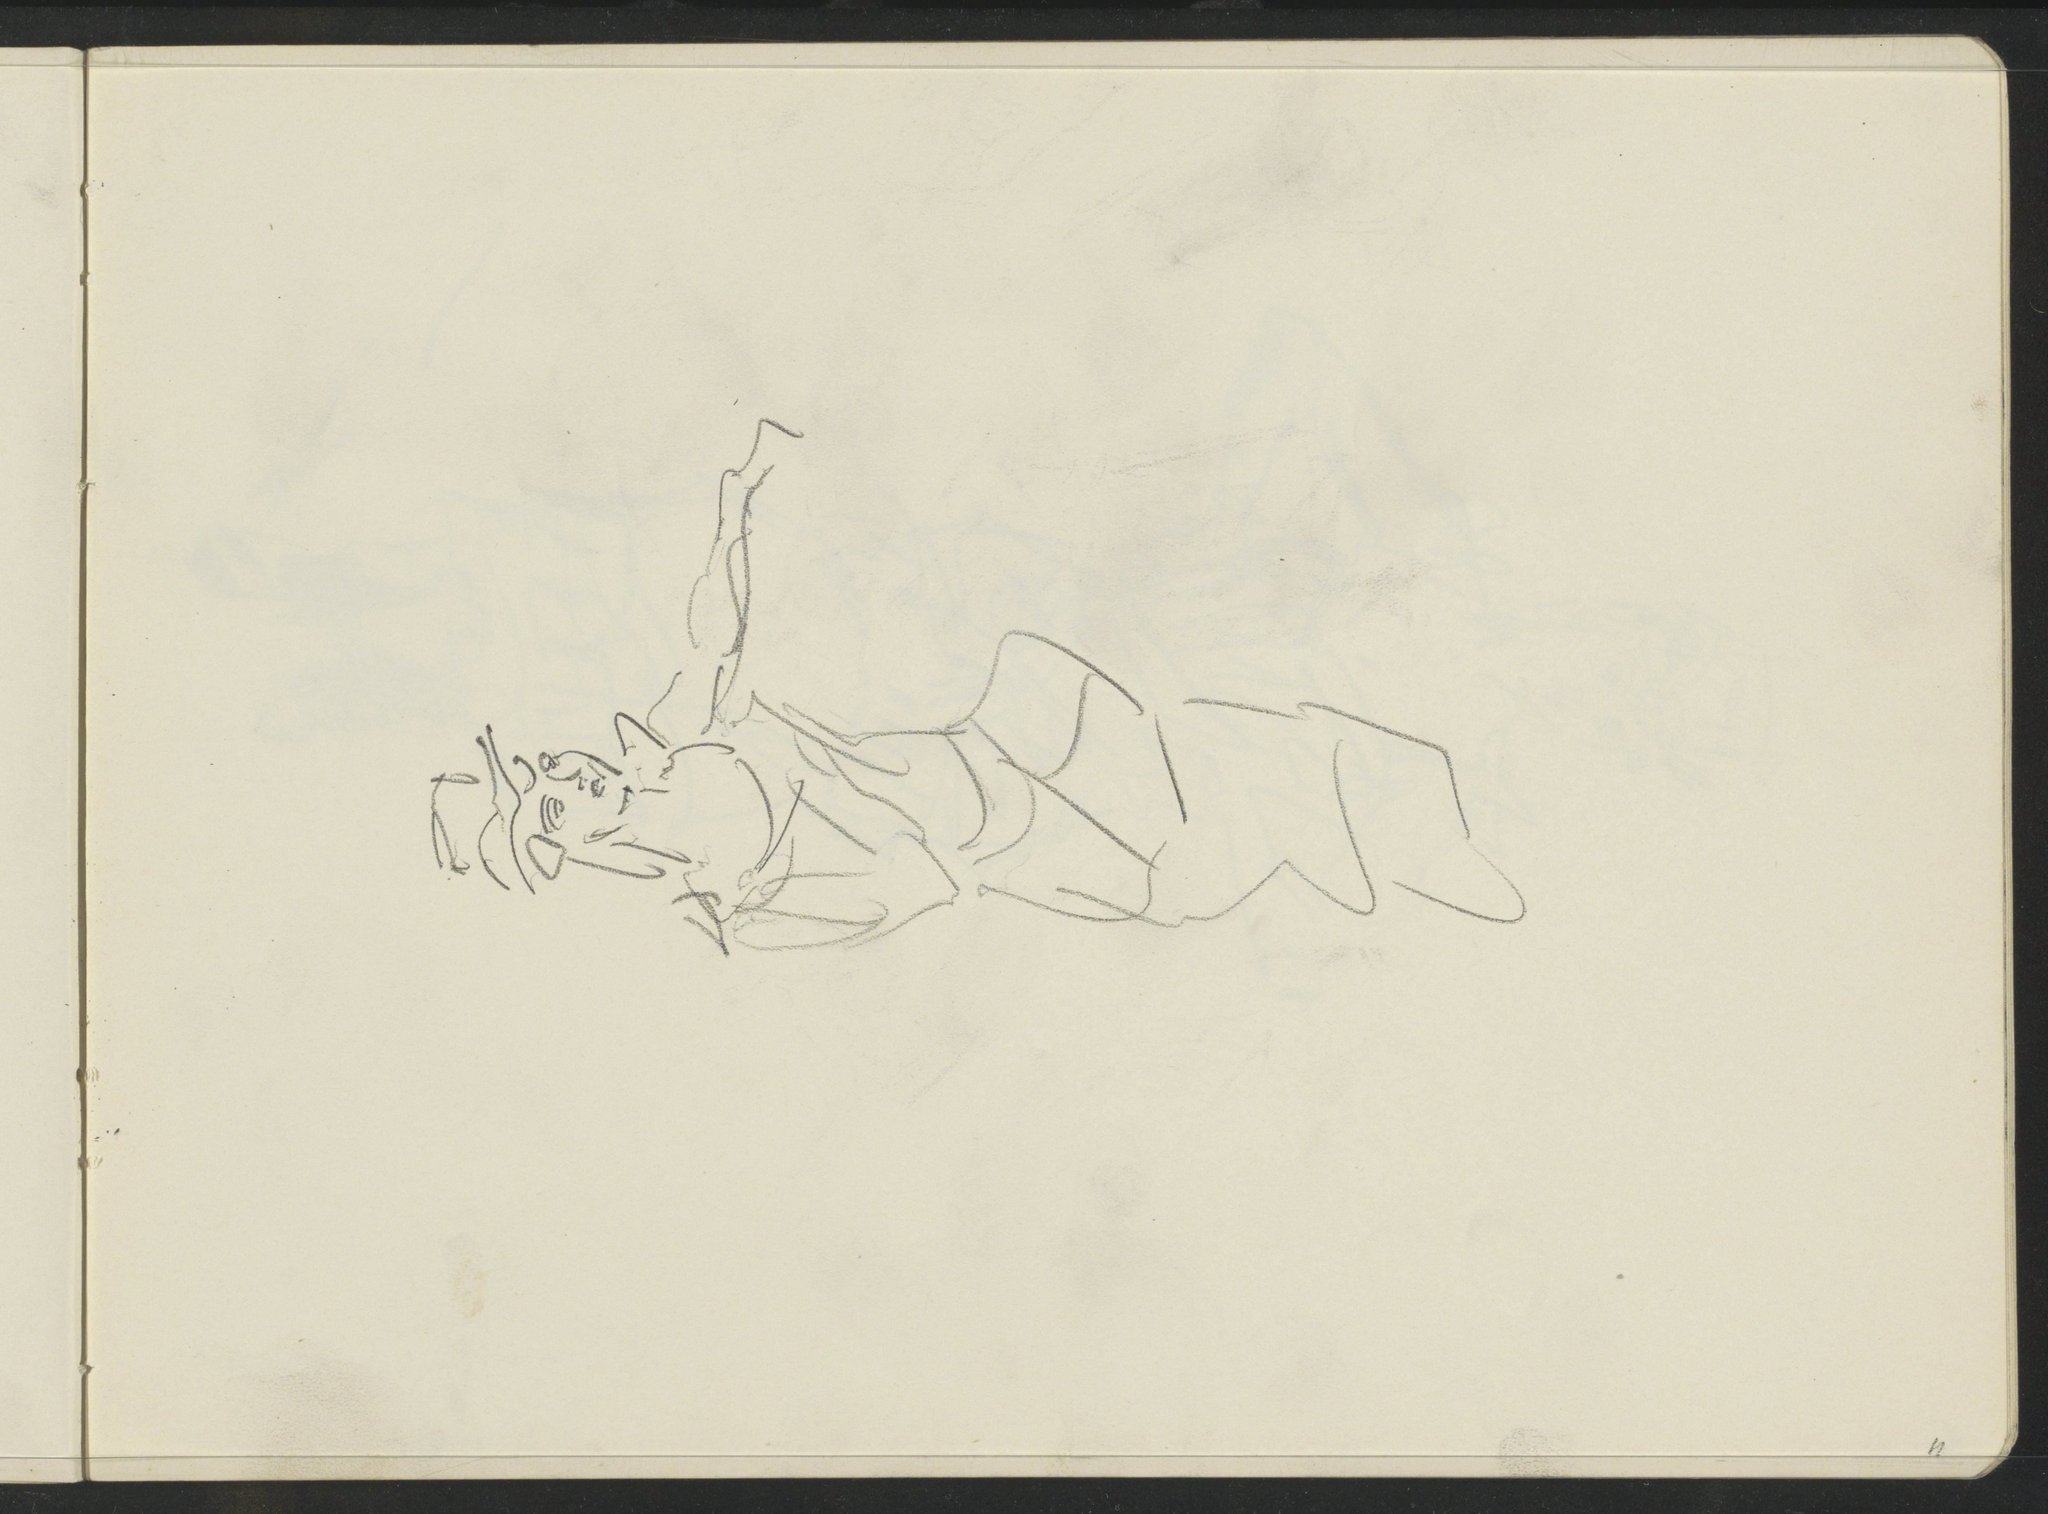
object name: sketchbook leaf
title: Staande vrouw met uitgestoken linkerarm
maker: isaac israels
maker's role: draughtsman, painter, print maker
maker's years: 1865-1934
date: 1915-1934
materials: paper, pencil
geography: the hague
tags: presenting a work of art to the public; performing, interpreting, reciting, adult woman (+ standing)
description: Ze draagt een hoed. Mogelijk een artiest. Blad 11 recto uit schetsboek XVIII met 35 bladen.